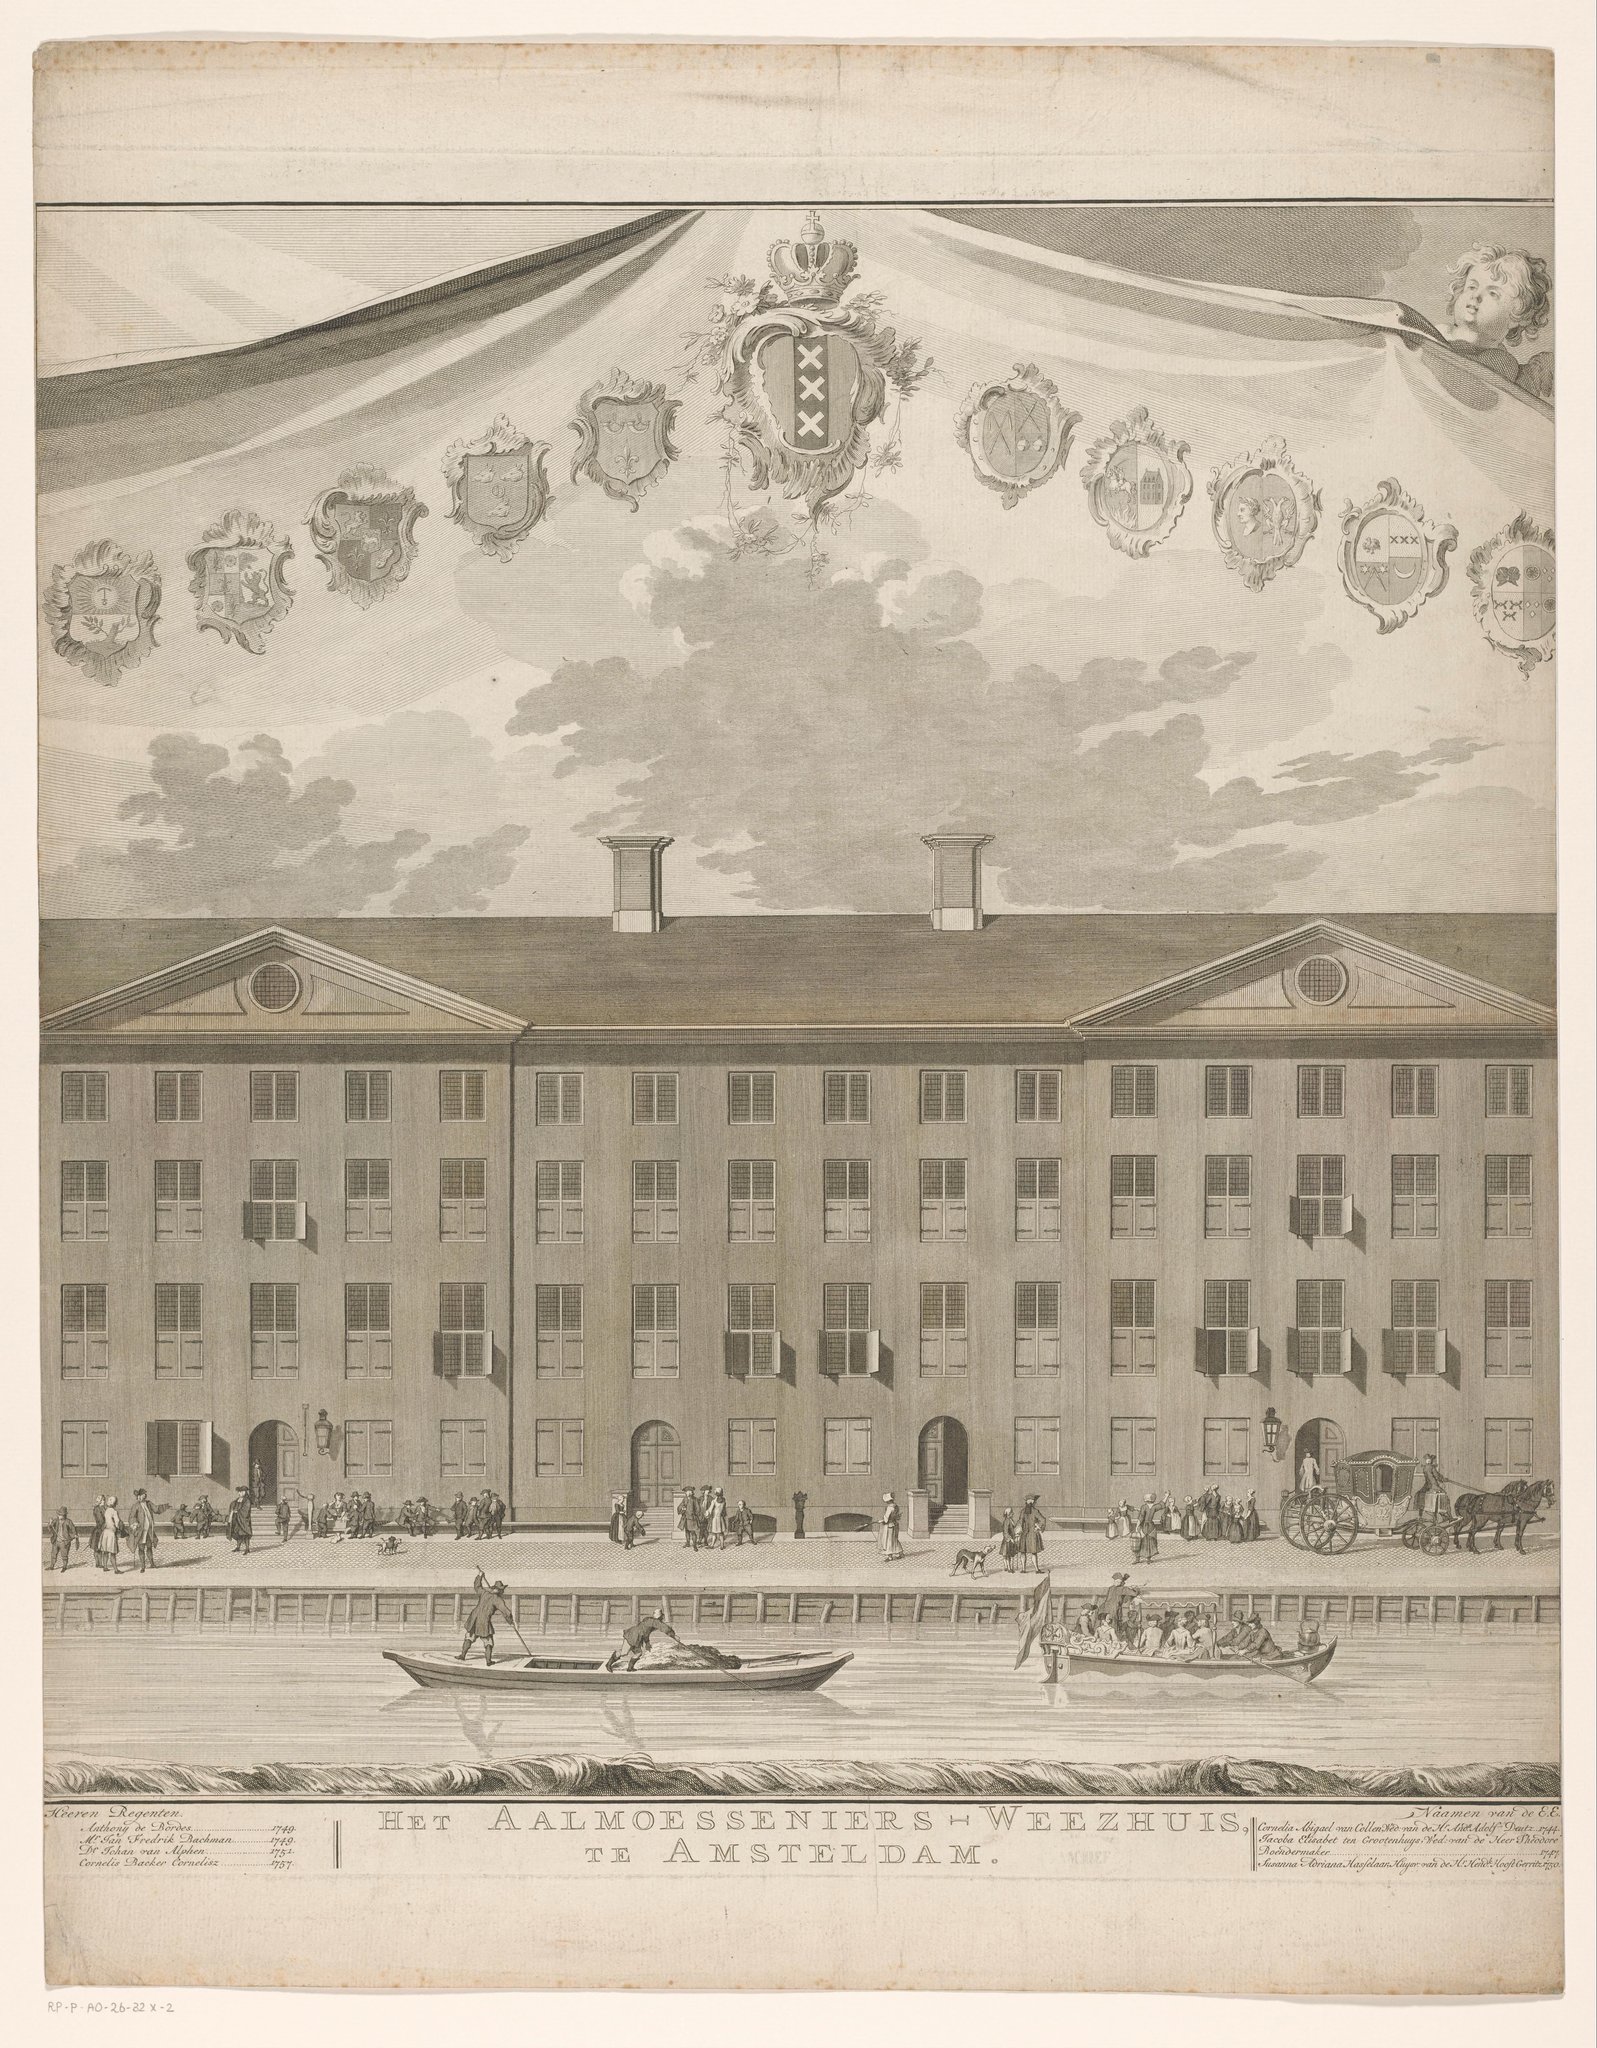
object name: print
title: Het Aalmoesseniers-Weezhuis te Amsteldam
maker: jan punt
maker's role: draughtsman, print maker, publisher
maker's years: 1711-1779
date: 1758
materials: paper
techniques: engraving, etching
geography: amsterdam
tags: coat of arms (as symbol of the state, etc.) (+ city; municipal), public welfare, orphanage, cupids: 'amores', 'amoretti', 'putti', canals, waters (in city) (+ city(-scape) with figures, staffage), armorial bearing, heraldry, street (+ city(-scape) with figures, staffage)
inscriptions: collector's mark: Lugt 2228, check stamp: ‘Archief Ministerie van Oorlog Afdeeling Genie’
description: Middelste deel van een gezicht op het Aalmoezeniersweeshuis te Amsterdam, bestaande uit drie delen.